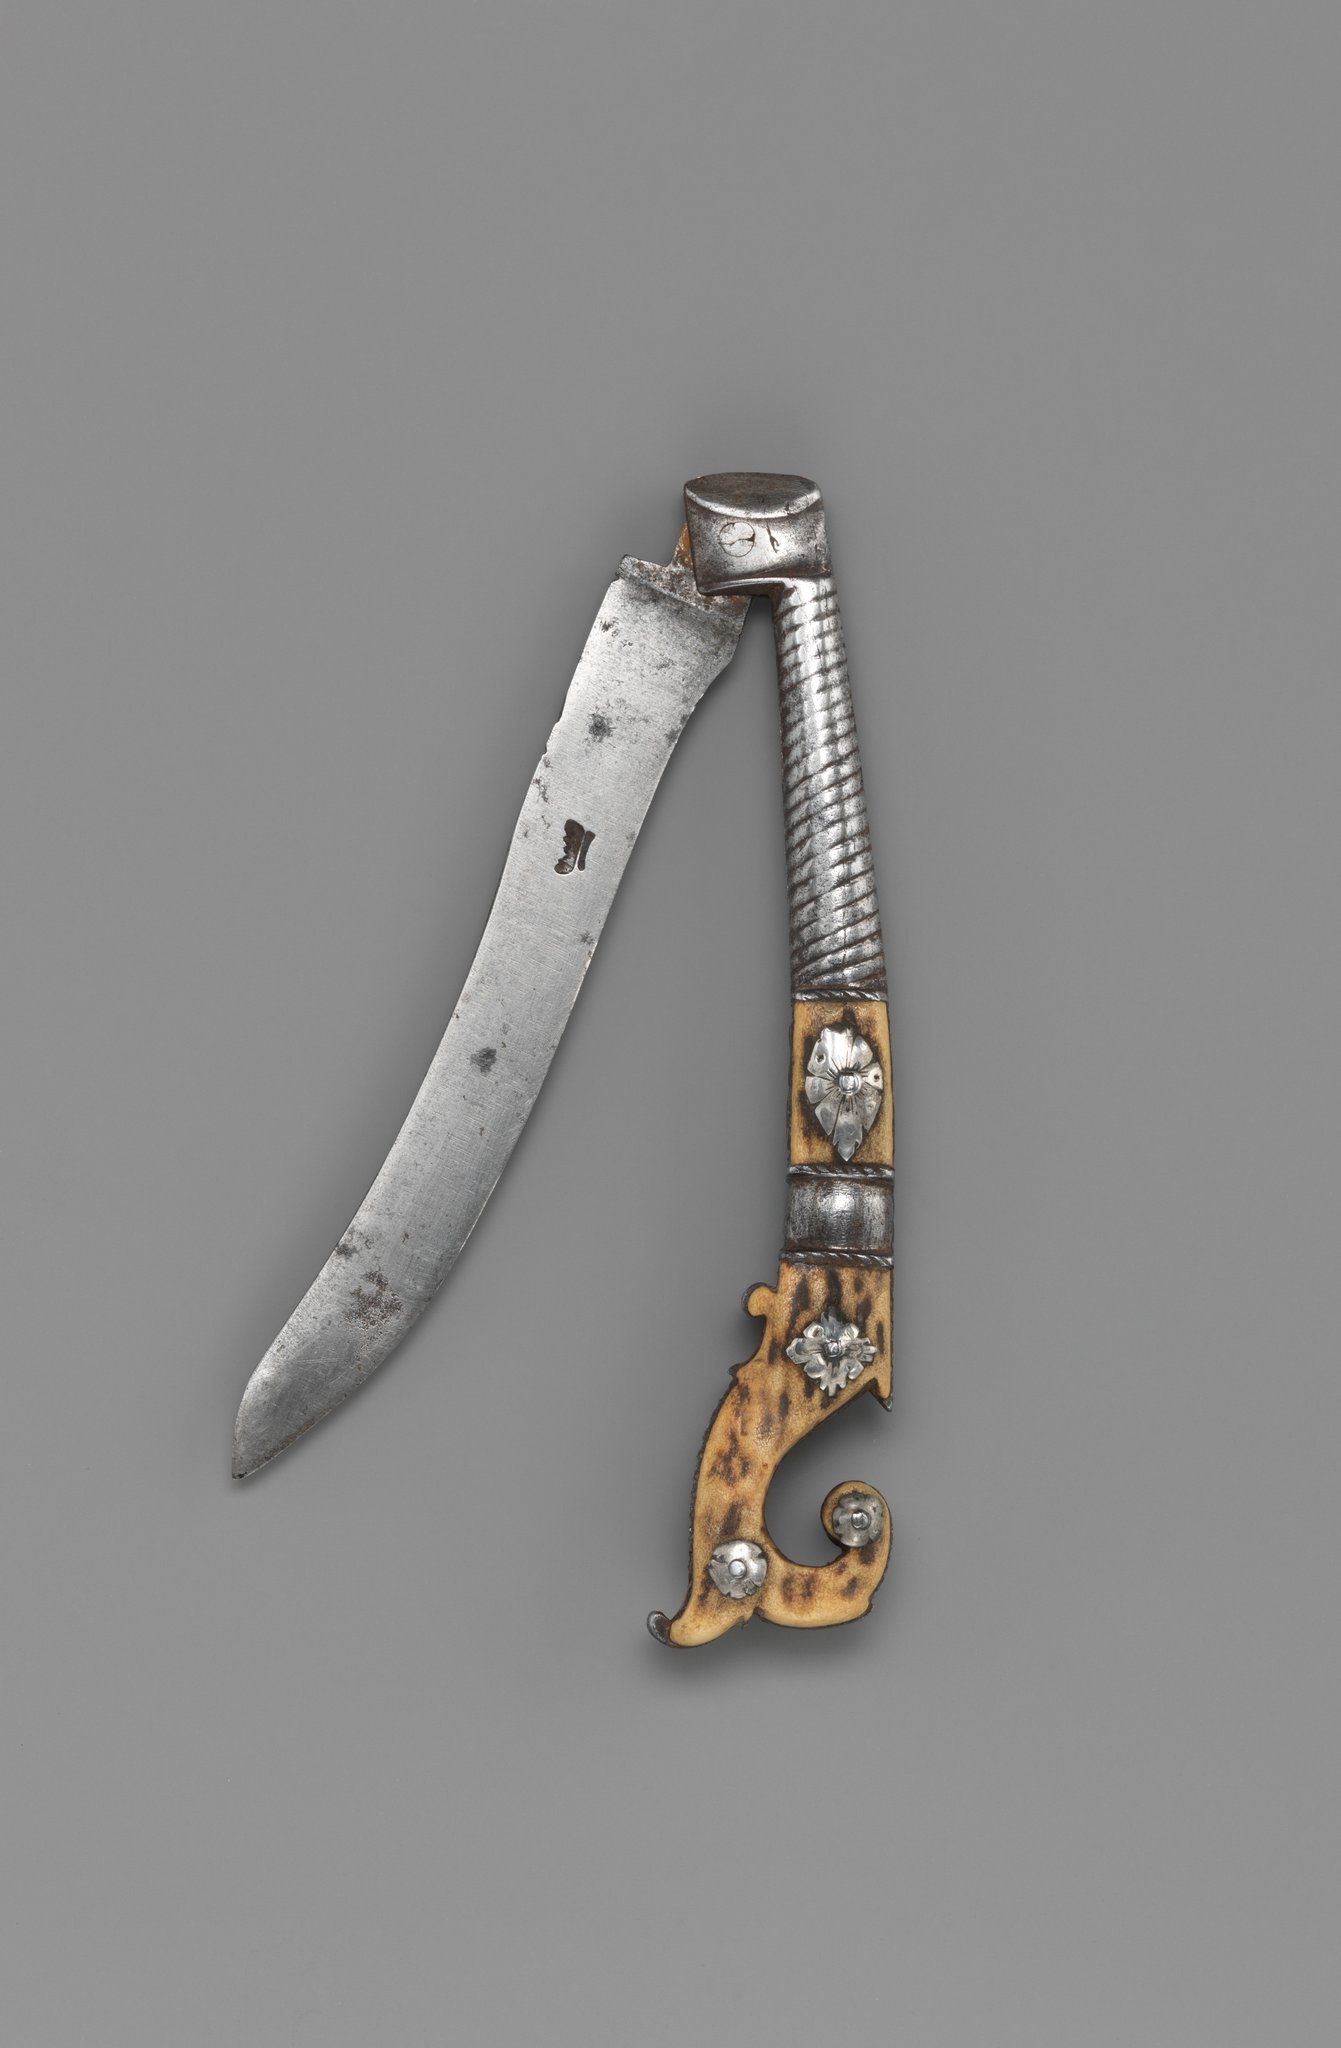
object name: folding table knife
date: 1767-1800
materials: silver, steel